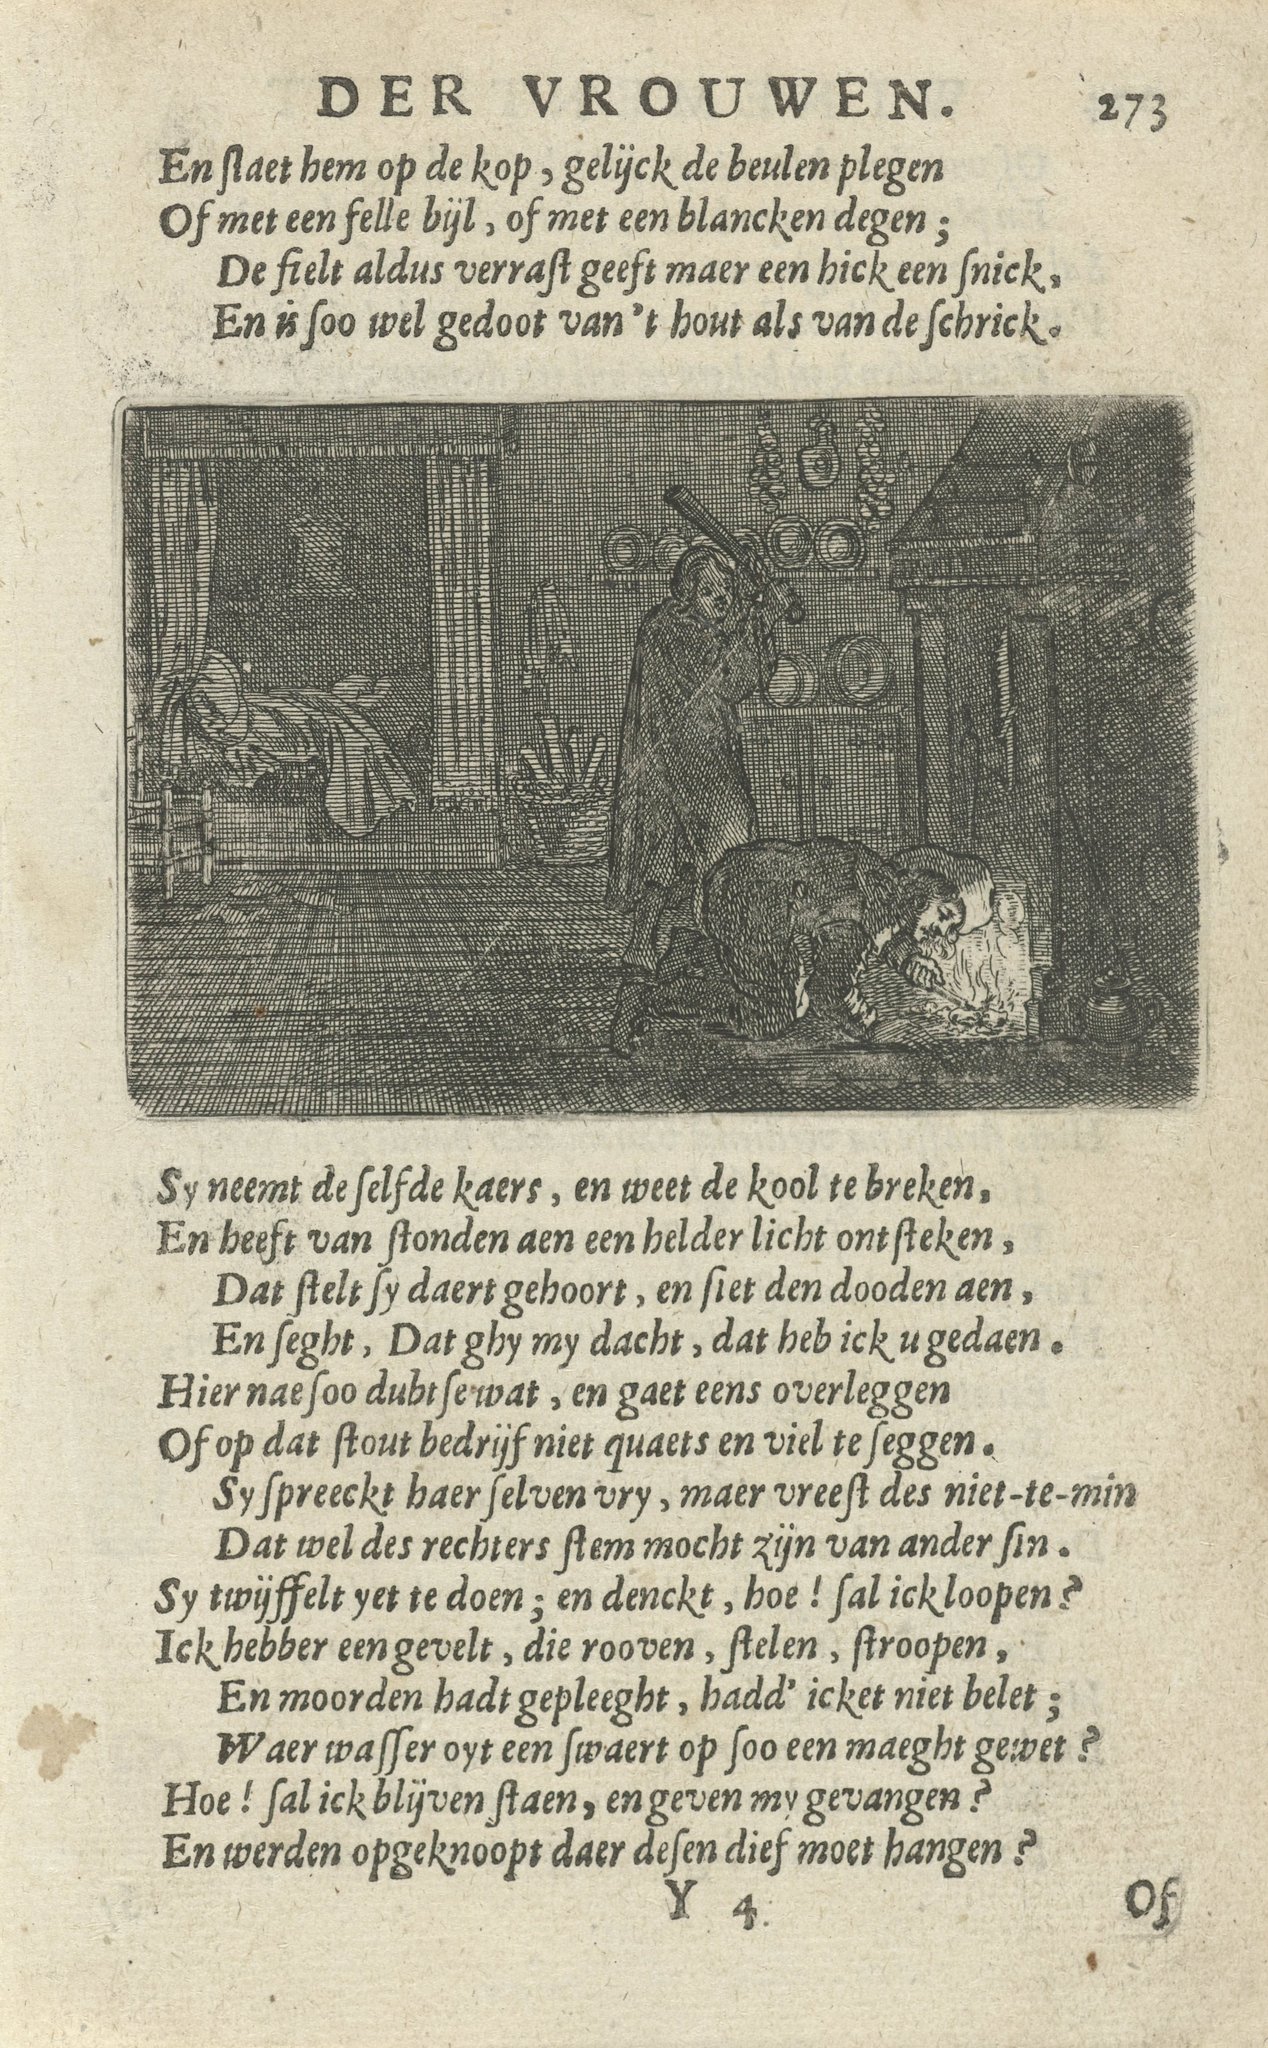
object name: book illustration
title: Vrouw haalt uit met een deegroller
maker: paulus lesire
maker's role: print maker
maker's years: 1611-1656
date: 1643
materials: paper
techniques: etching, letterpress printing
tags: kitchen-interior, violent death, being killed; being mishandled and maltreated; seeking death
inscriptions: collector's mark: Lugt 2760, collector's mark: Lugt 2228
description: Illustratie opgenomen in: Beverwyck, Johannes van. Van de wtnementheyt des vrouwelicken geslachts. Dordrecht: Hendrick van Esch voor Jasper Goris, 1643.